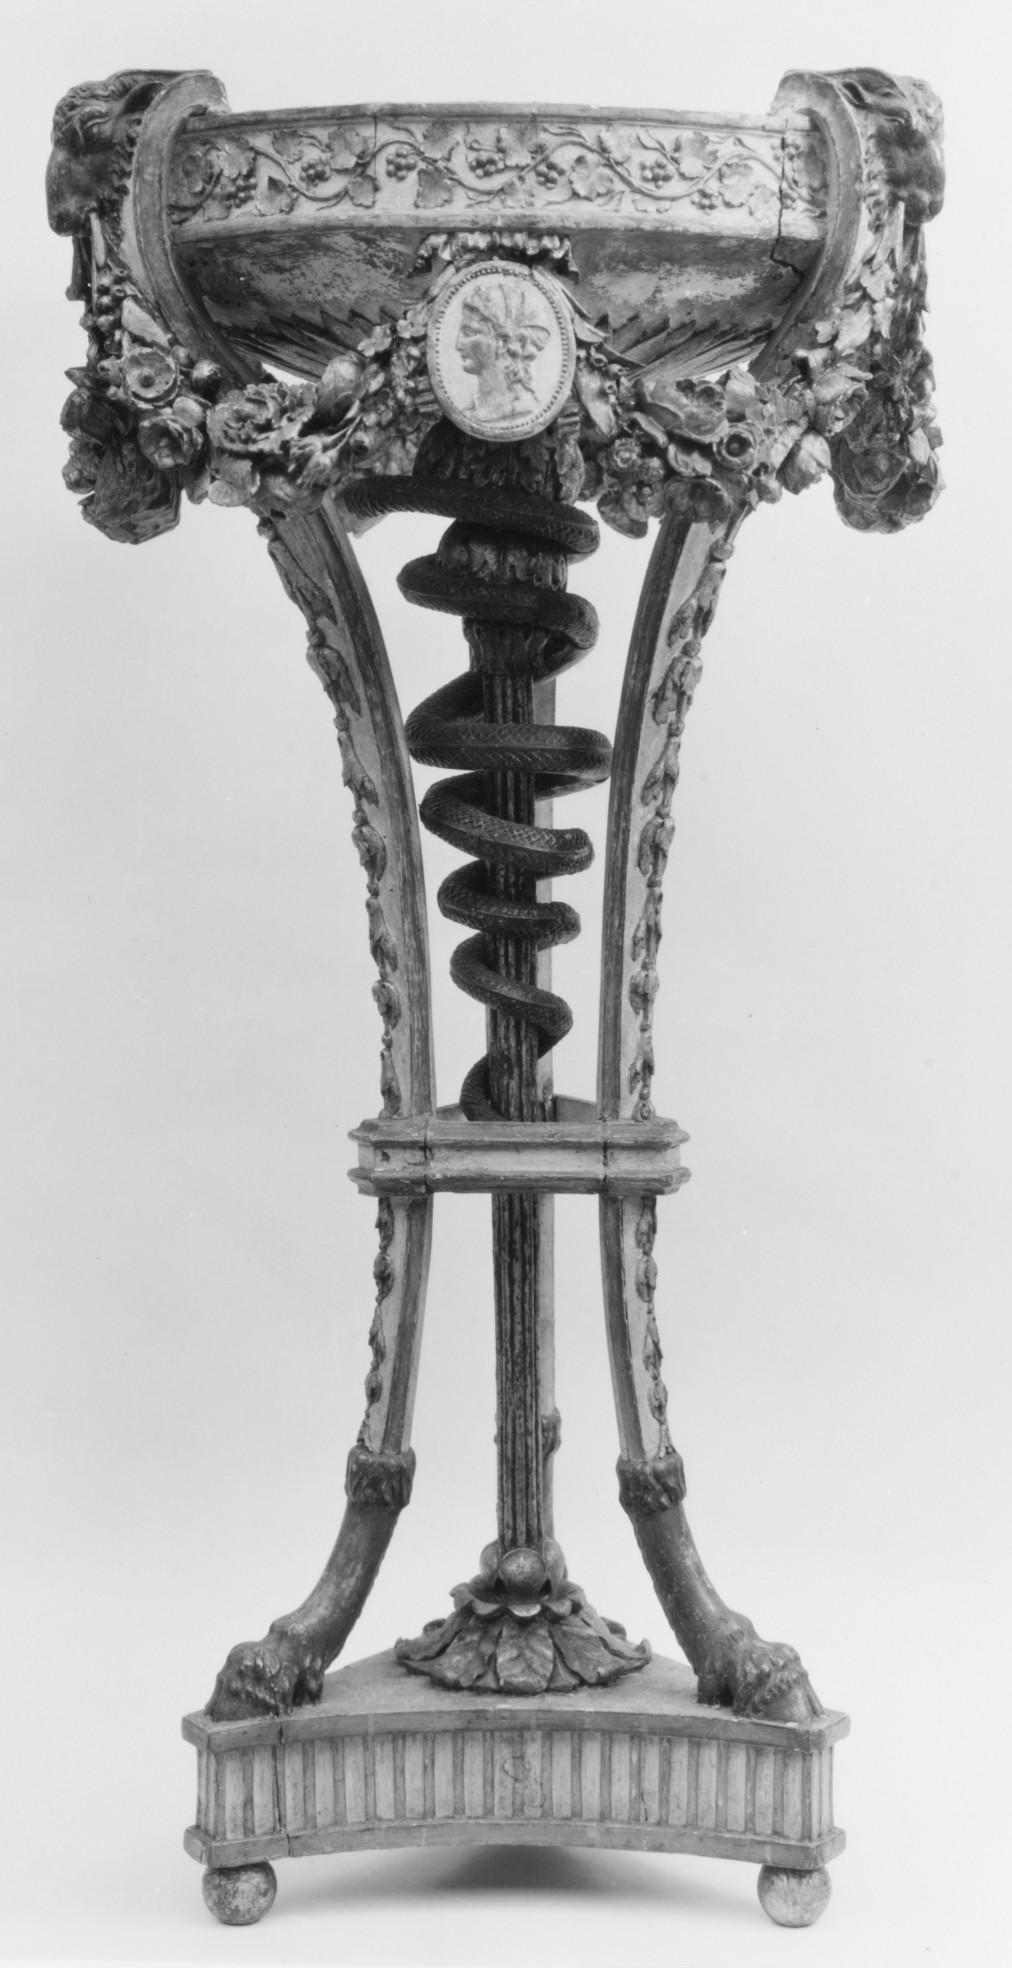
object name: athéniennes with basin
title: Pair of athéniennes with basins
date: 1774-1793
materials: gilt copper, wood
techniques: carving, gilding, painting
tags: serpents